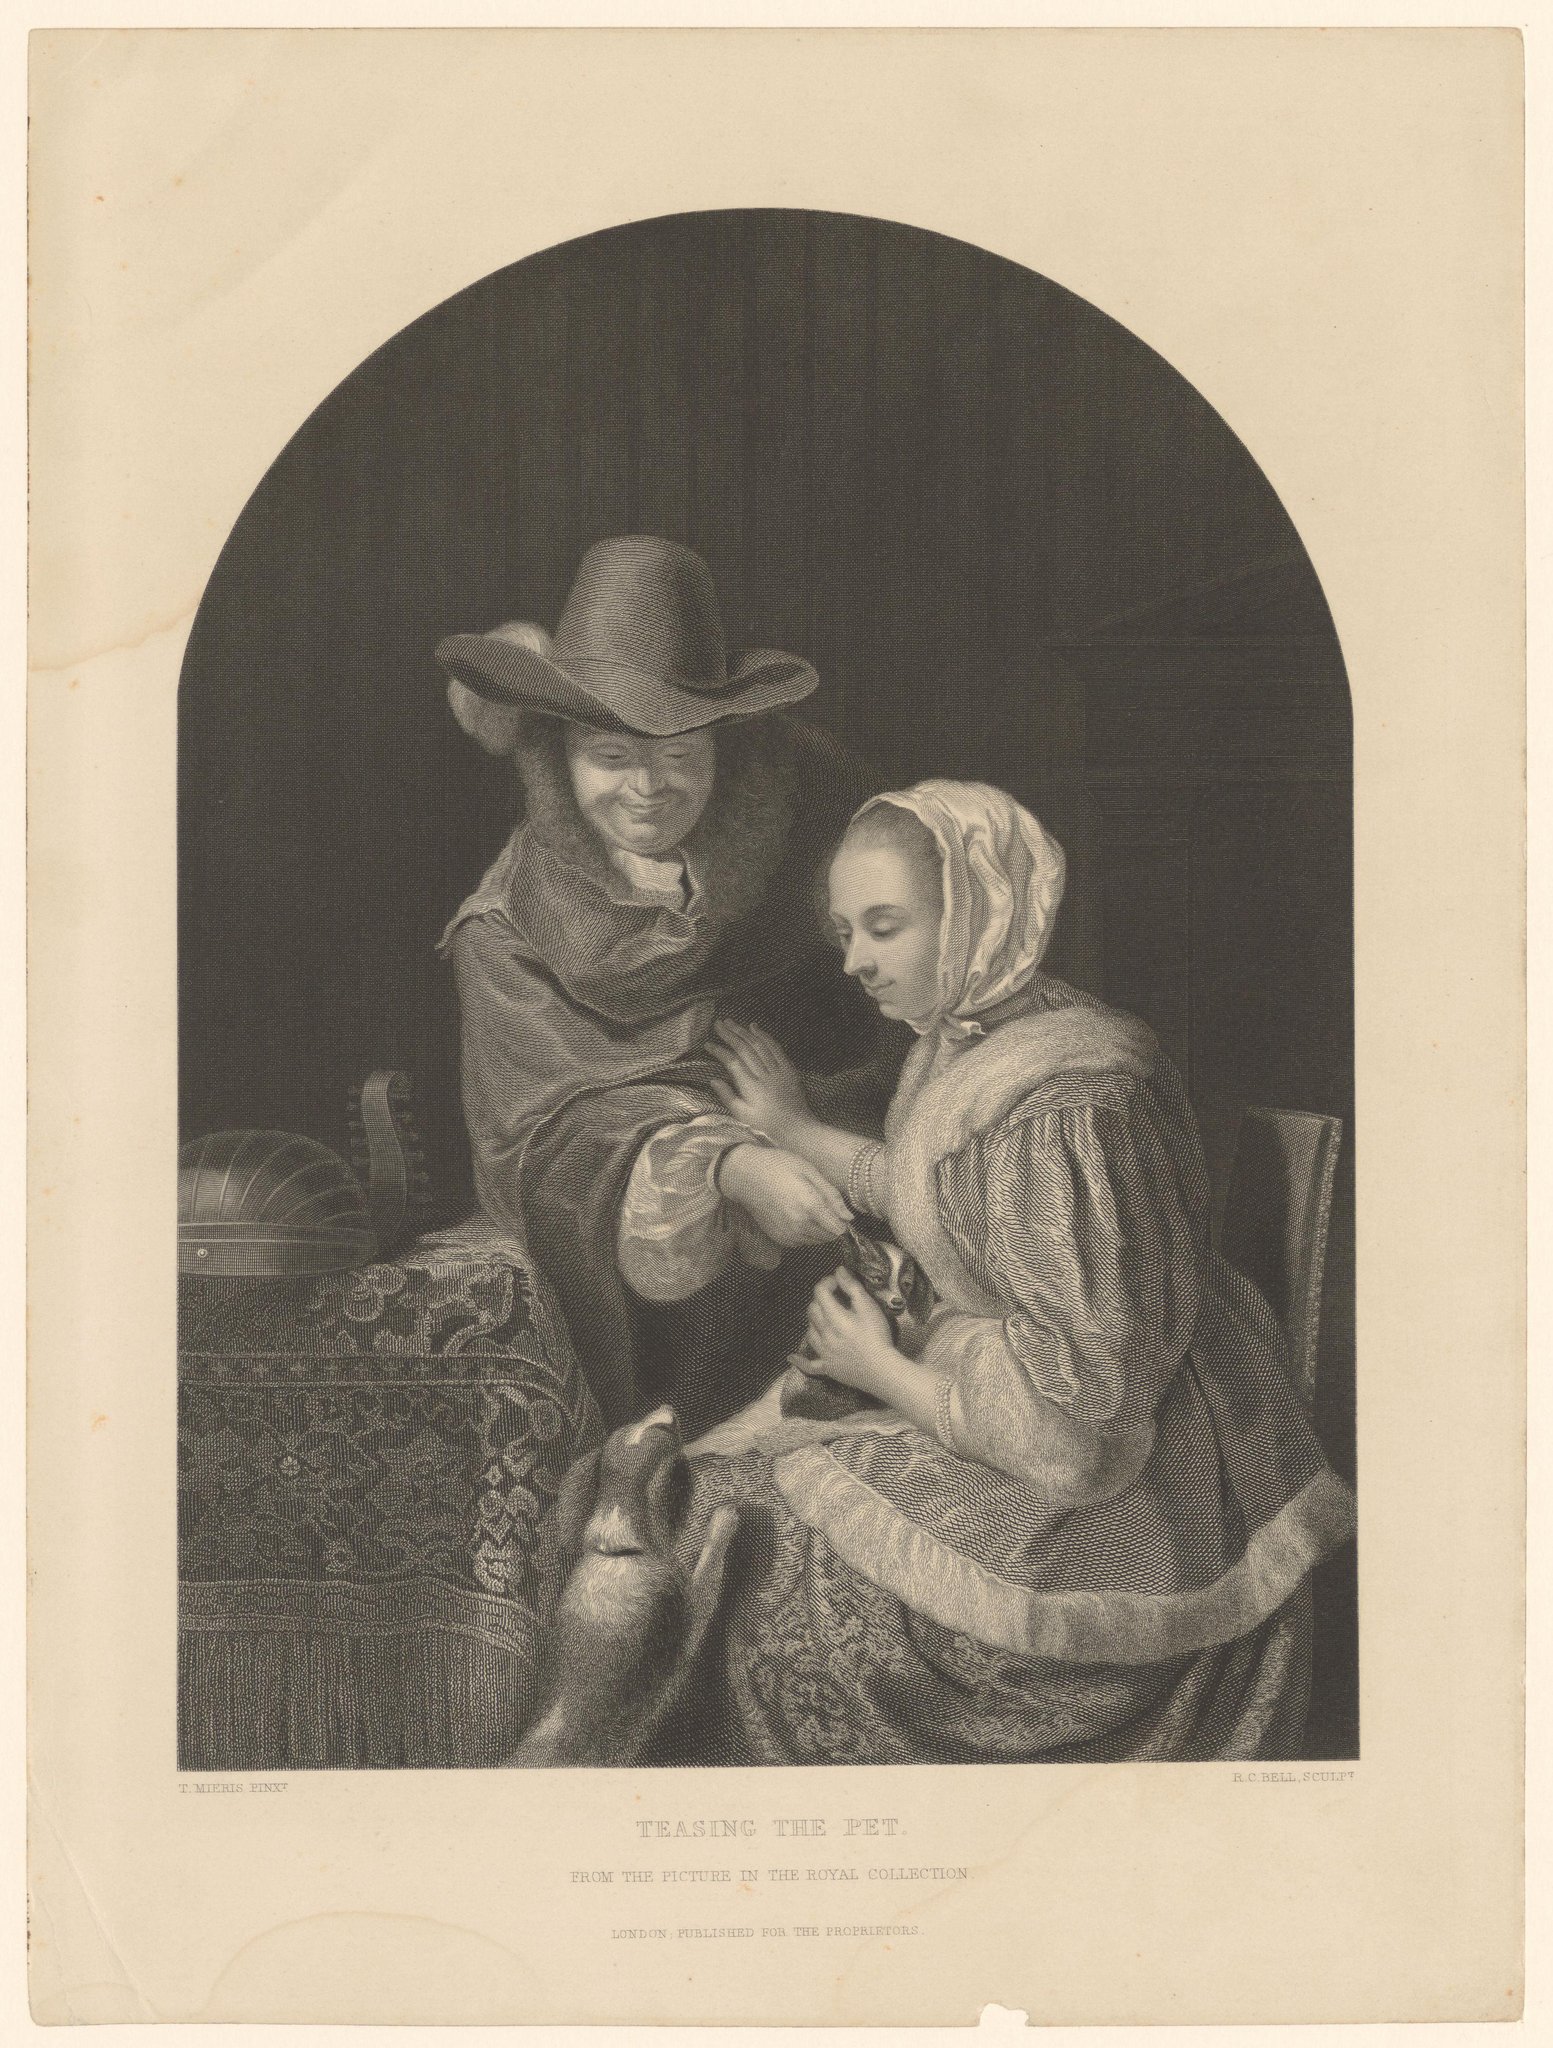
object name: book illustration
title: Man trekt aan het oor van een hondje dat bij een vrouw op schoot zit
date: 1857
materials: paper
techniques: engraving, etching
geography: london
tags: dog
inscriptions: collector's mark: Lugt 2228